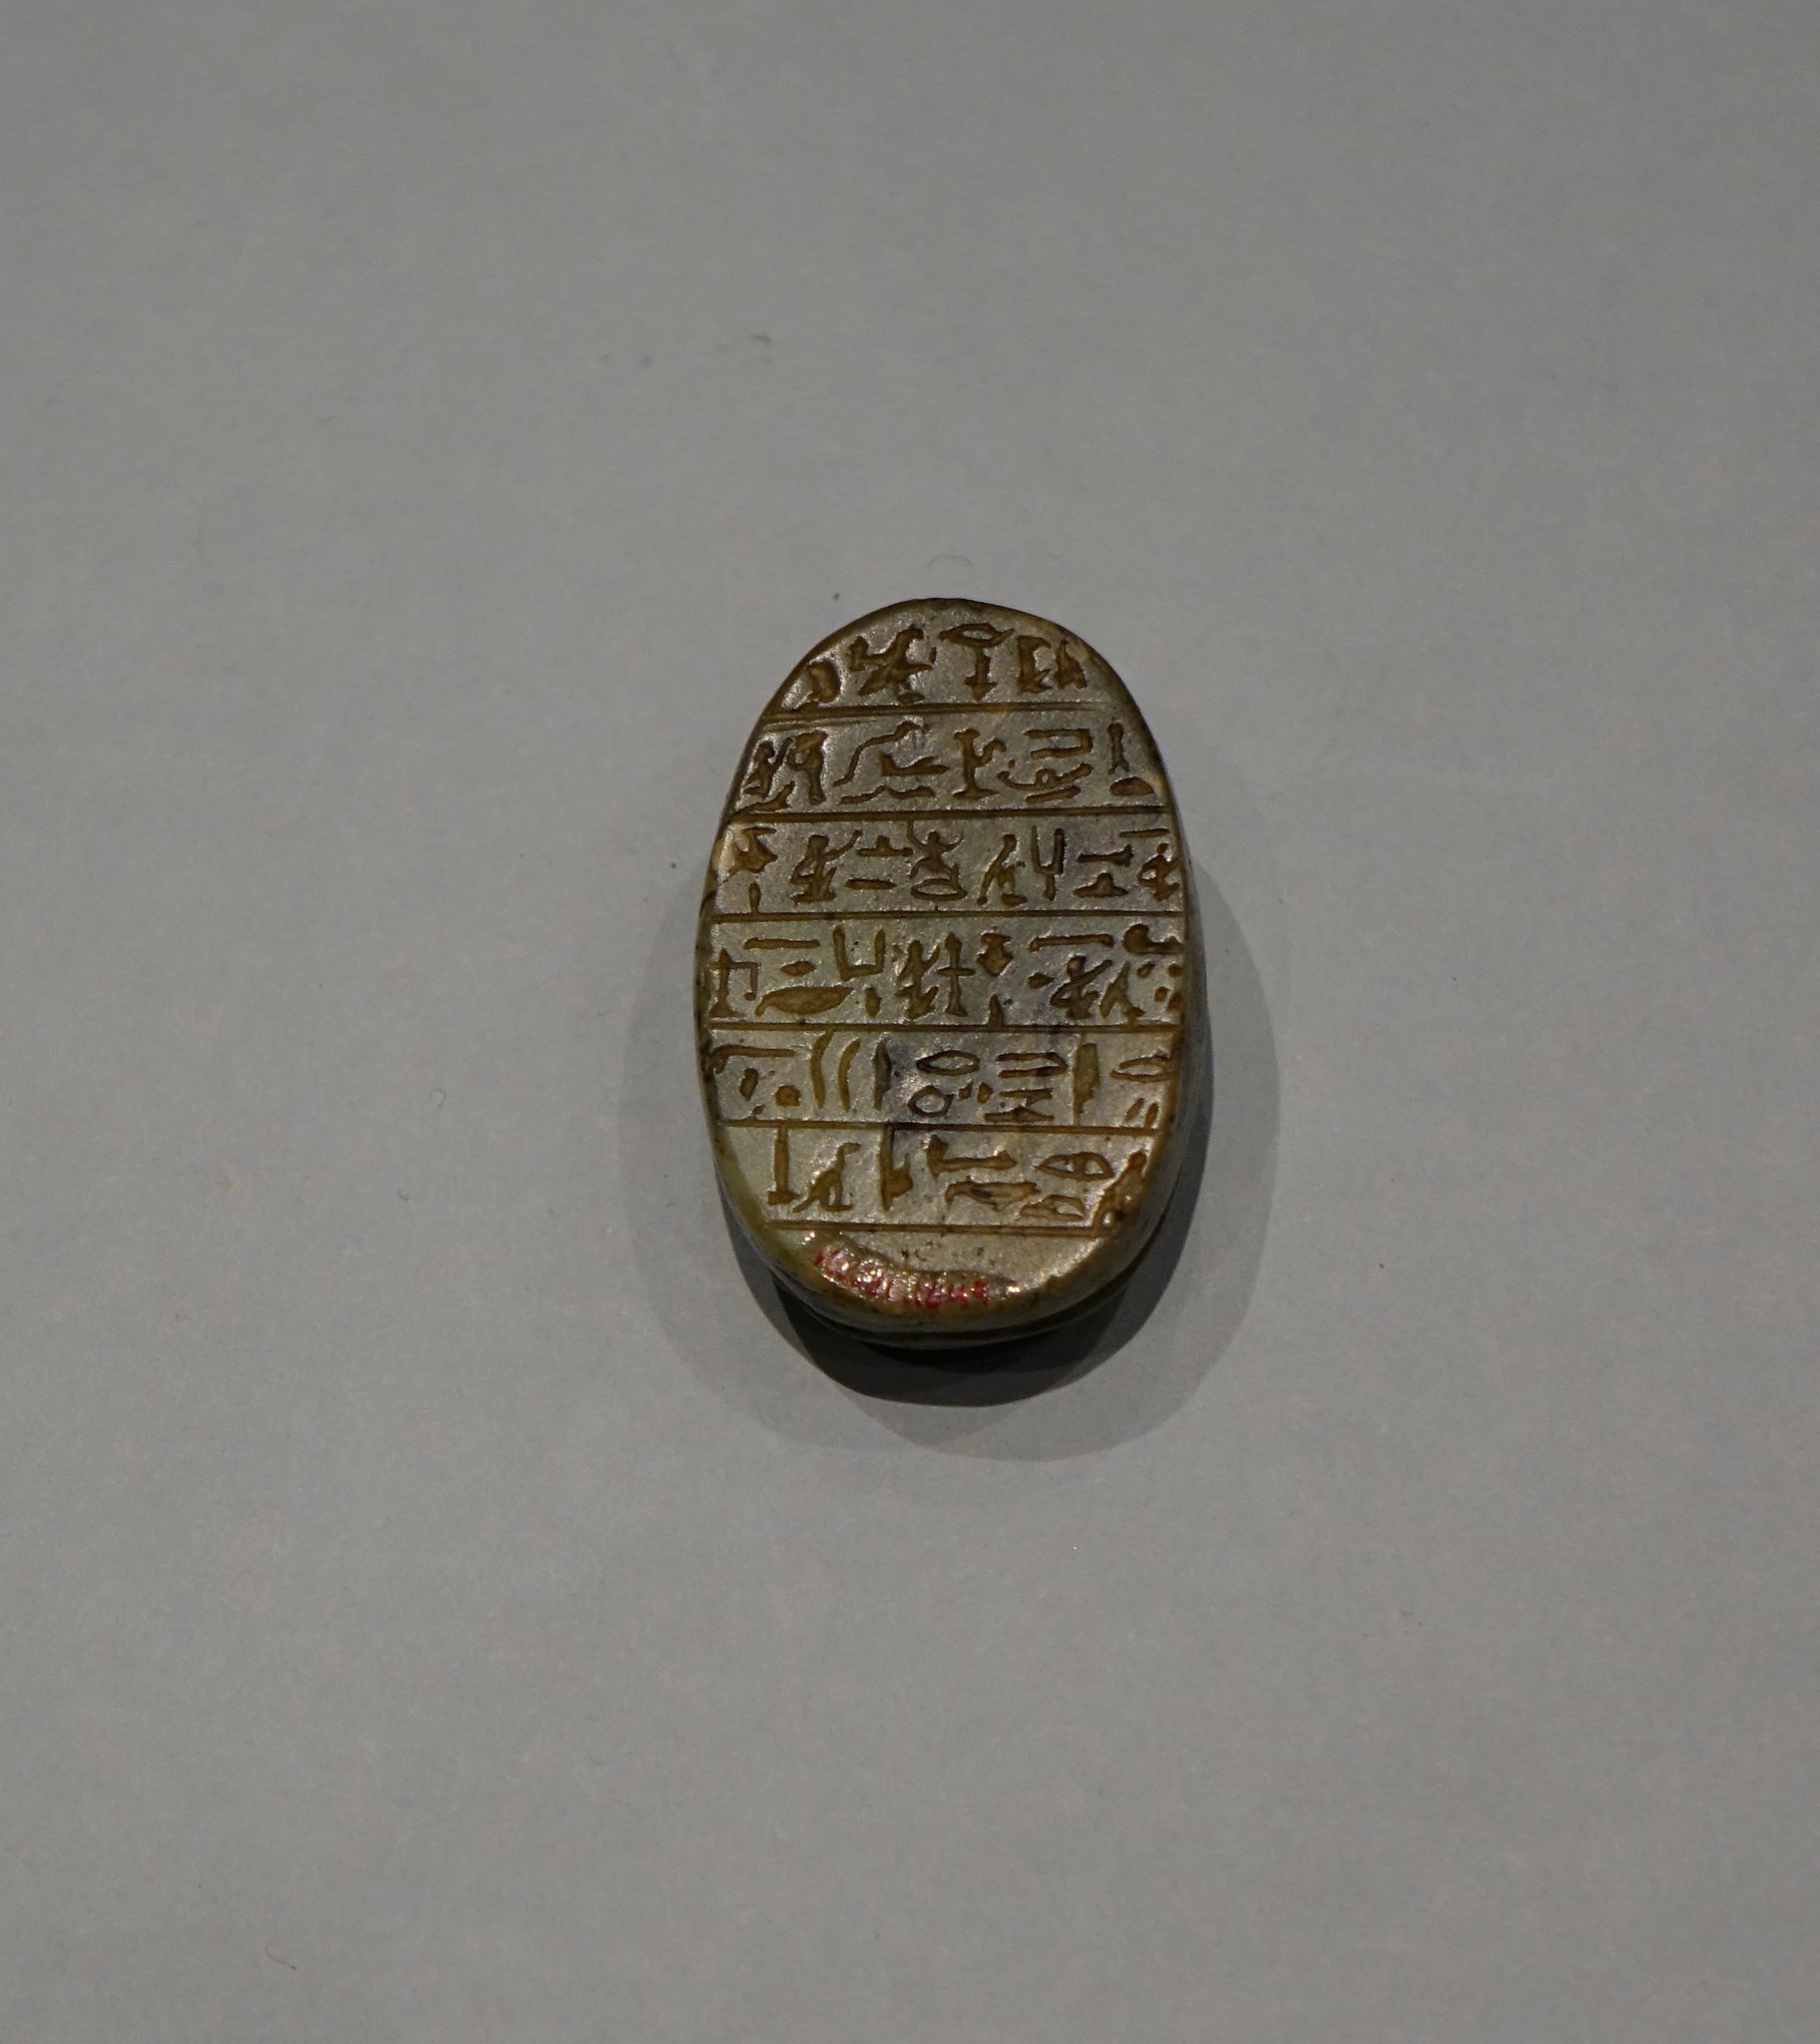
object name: heart scarab, ptahemua, pashed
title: Heart Scarab of Ptahemua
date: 1295-1186 BCE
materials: stone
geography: egypt